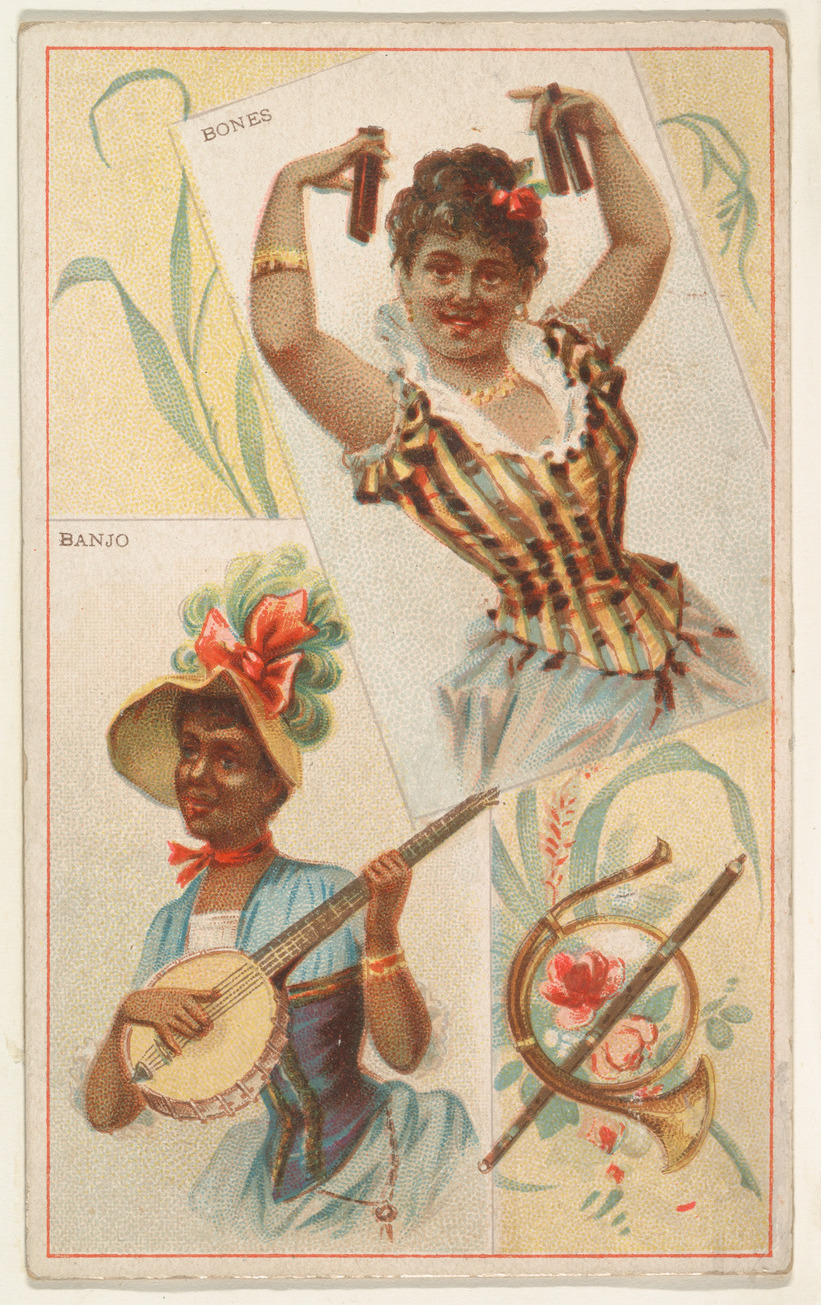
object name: print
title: Bones and Banjo, from the Musical Instruments series (N121) issued by Duke Sons & Co. to promote Honest Long Cut Tobacco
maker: w. duke, sons & co.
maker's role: publisher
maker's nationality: american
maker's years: 1870-1920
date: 1888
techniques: color lithograph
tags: musical instruments,women